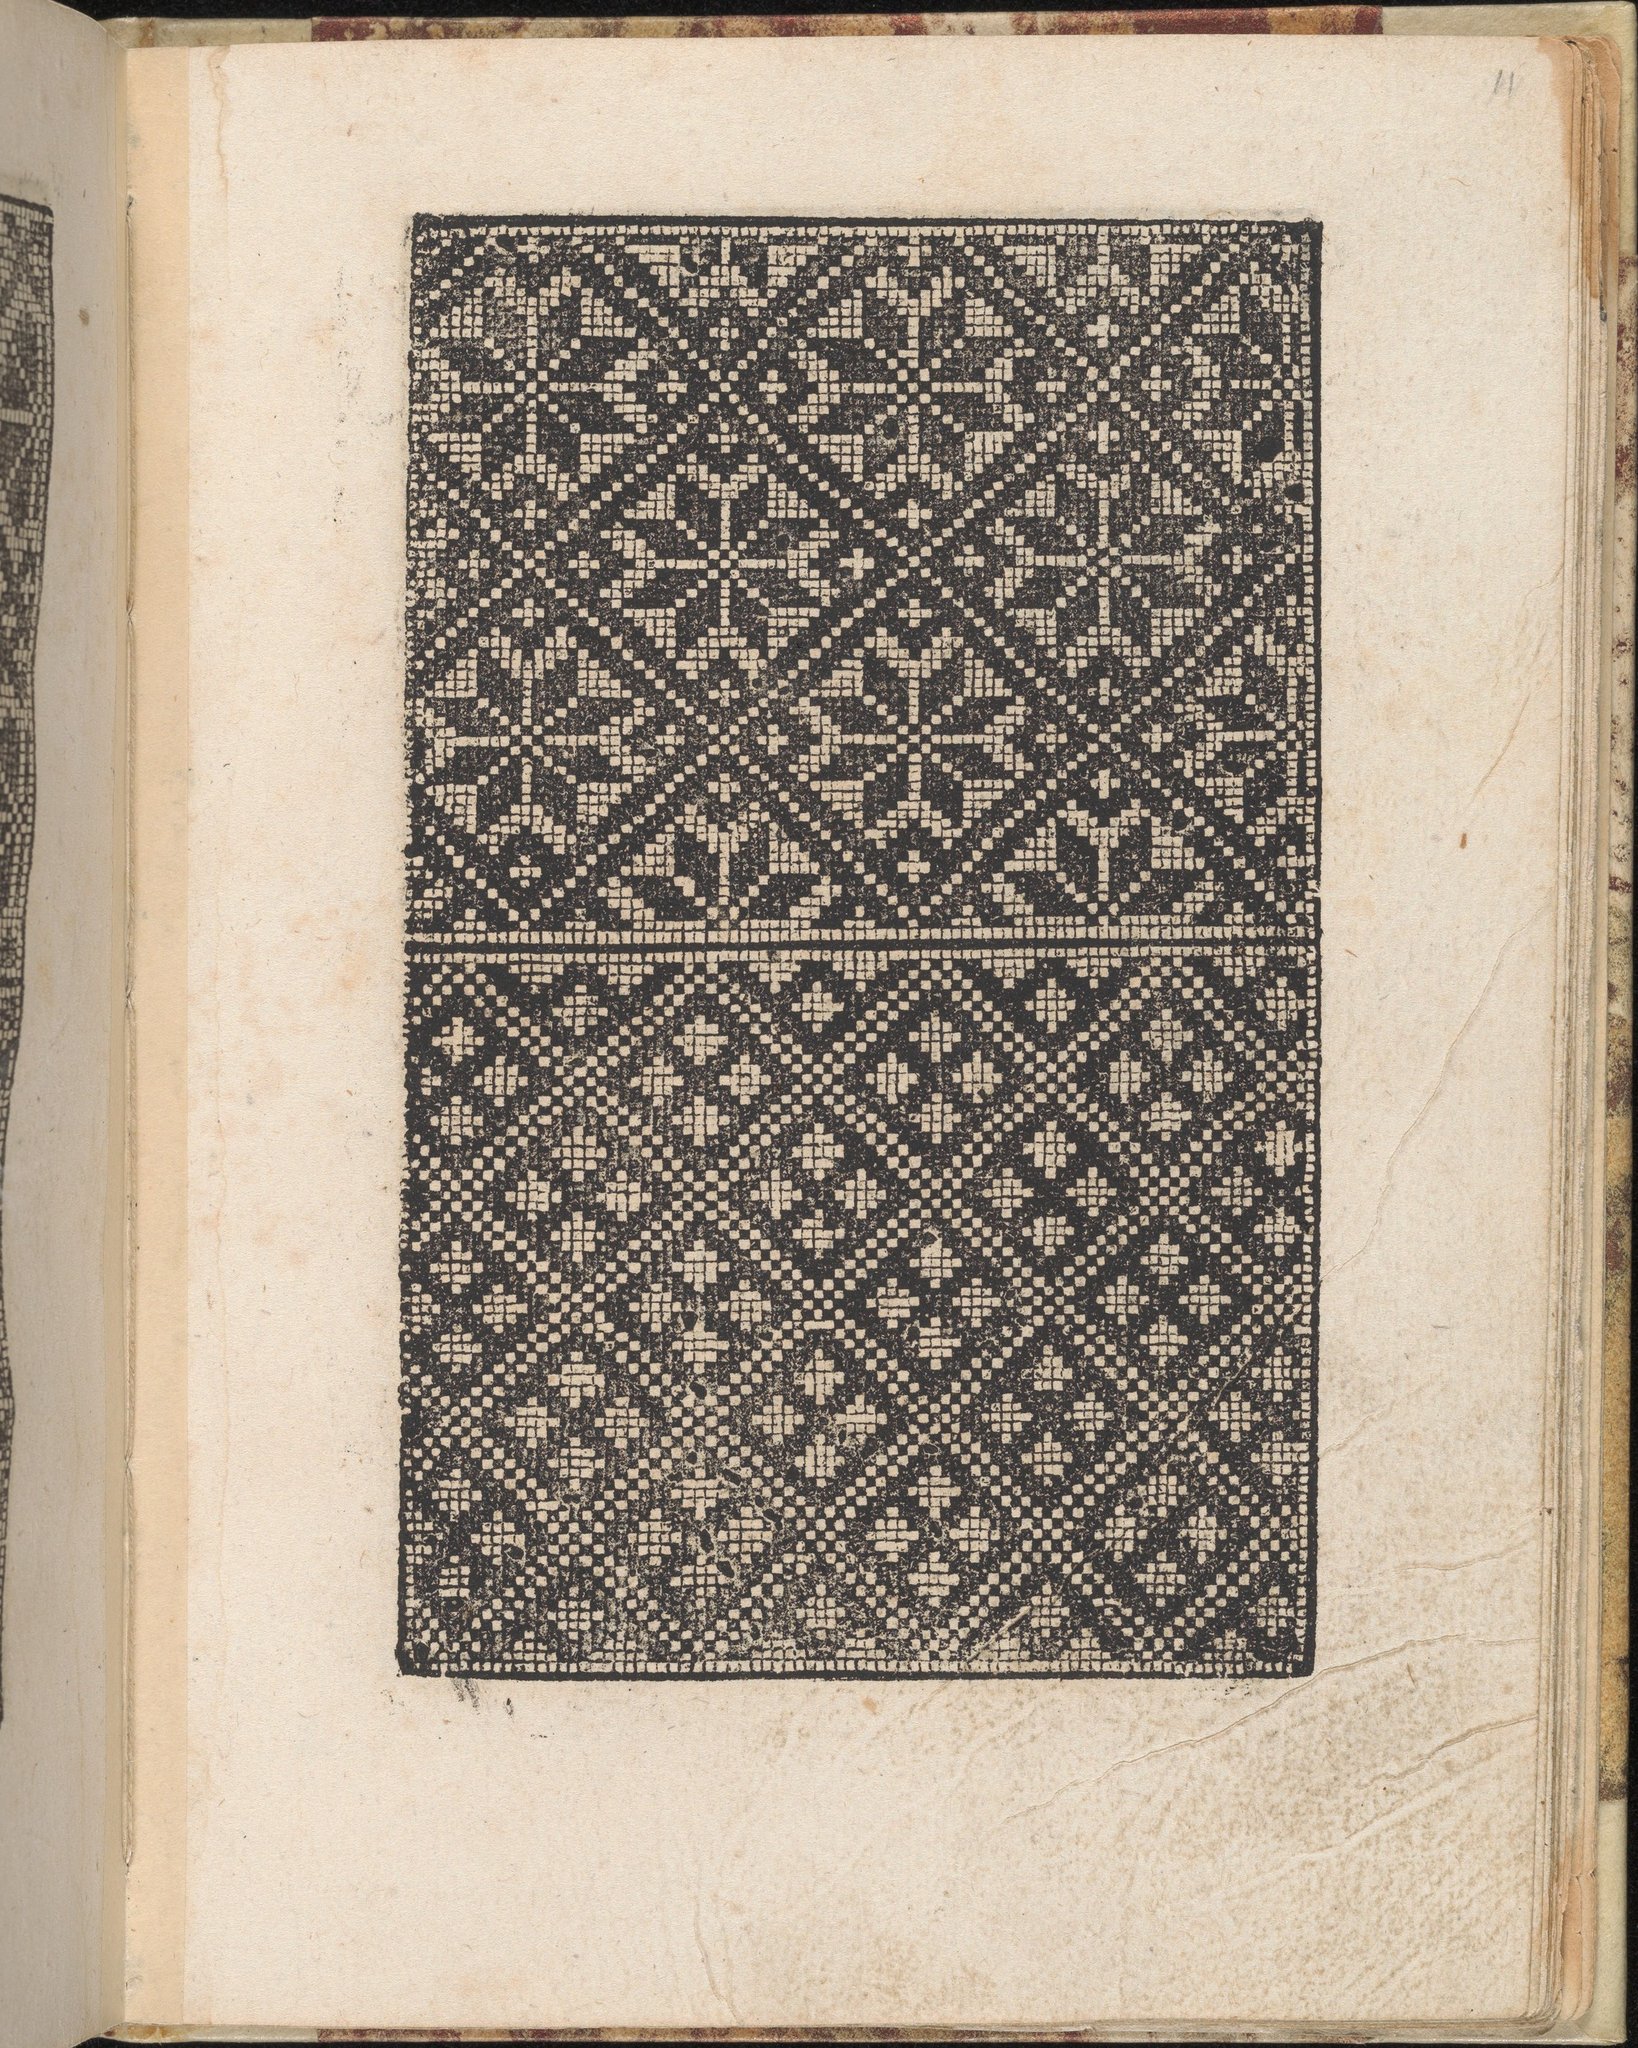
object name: book print ornament architecture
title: Ein new getruckt model Büchli...Page 10, verso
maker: johann schönsperger the younger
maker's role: publisher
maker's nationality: german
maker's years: 1490-1550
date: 1529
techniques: woodcut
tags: ornament